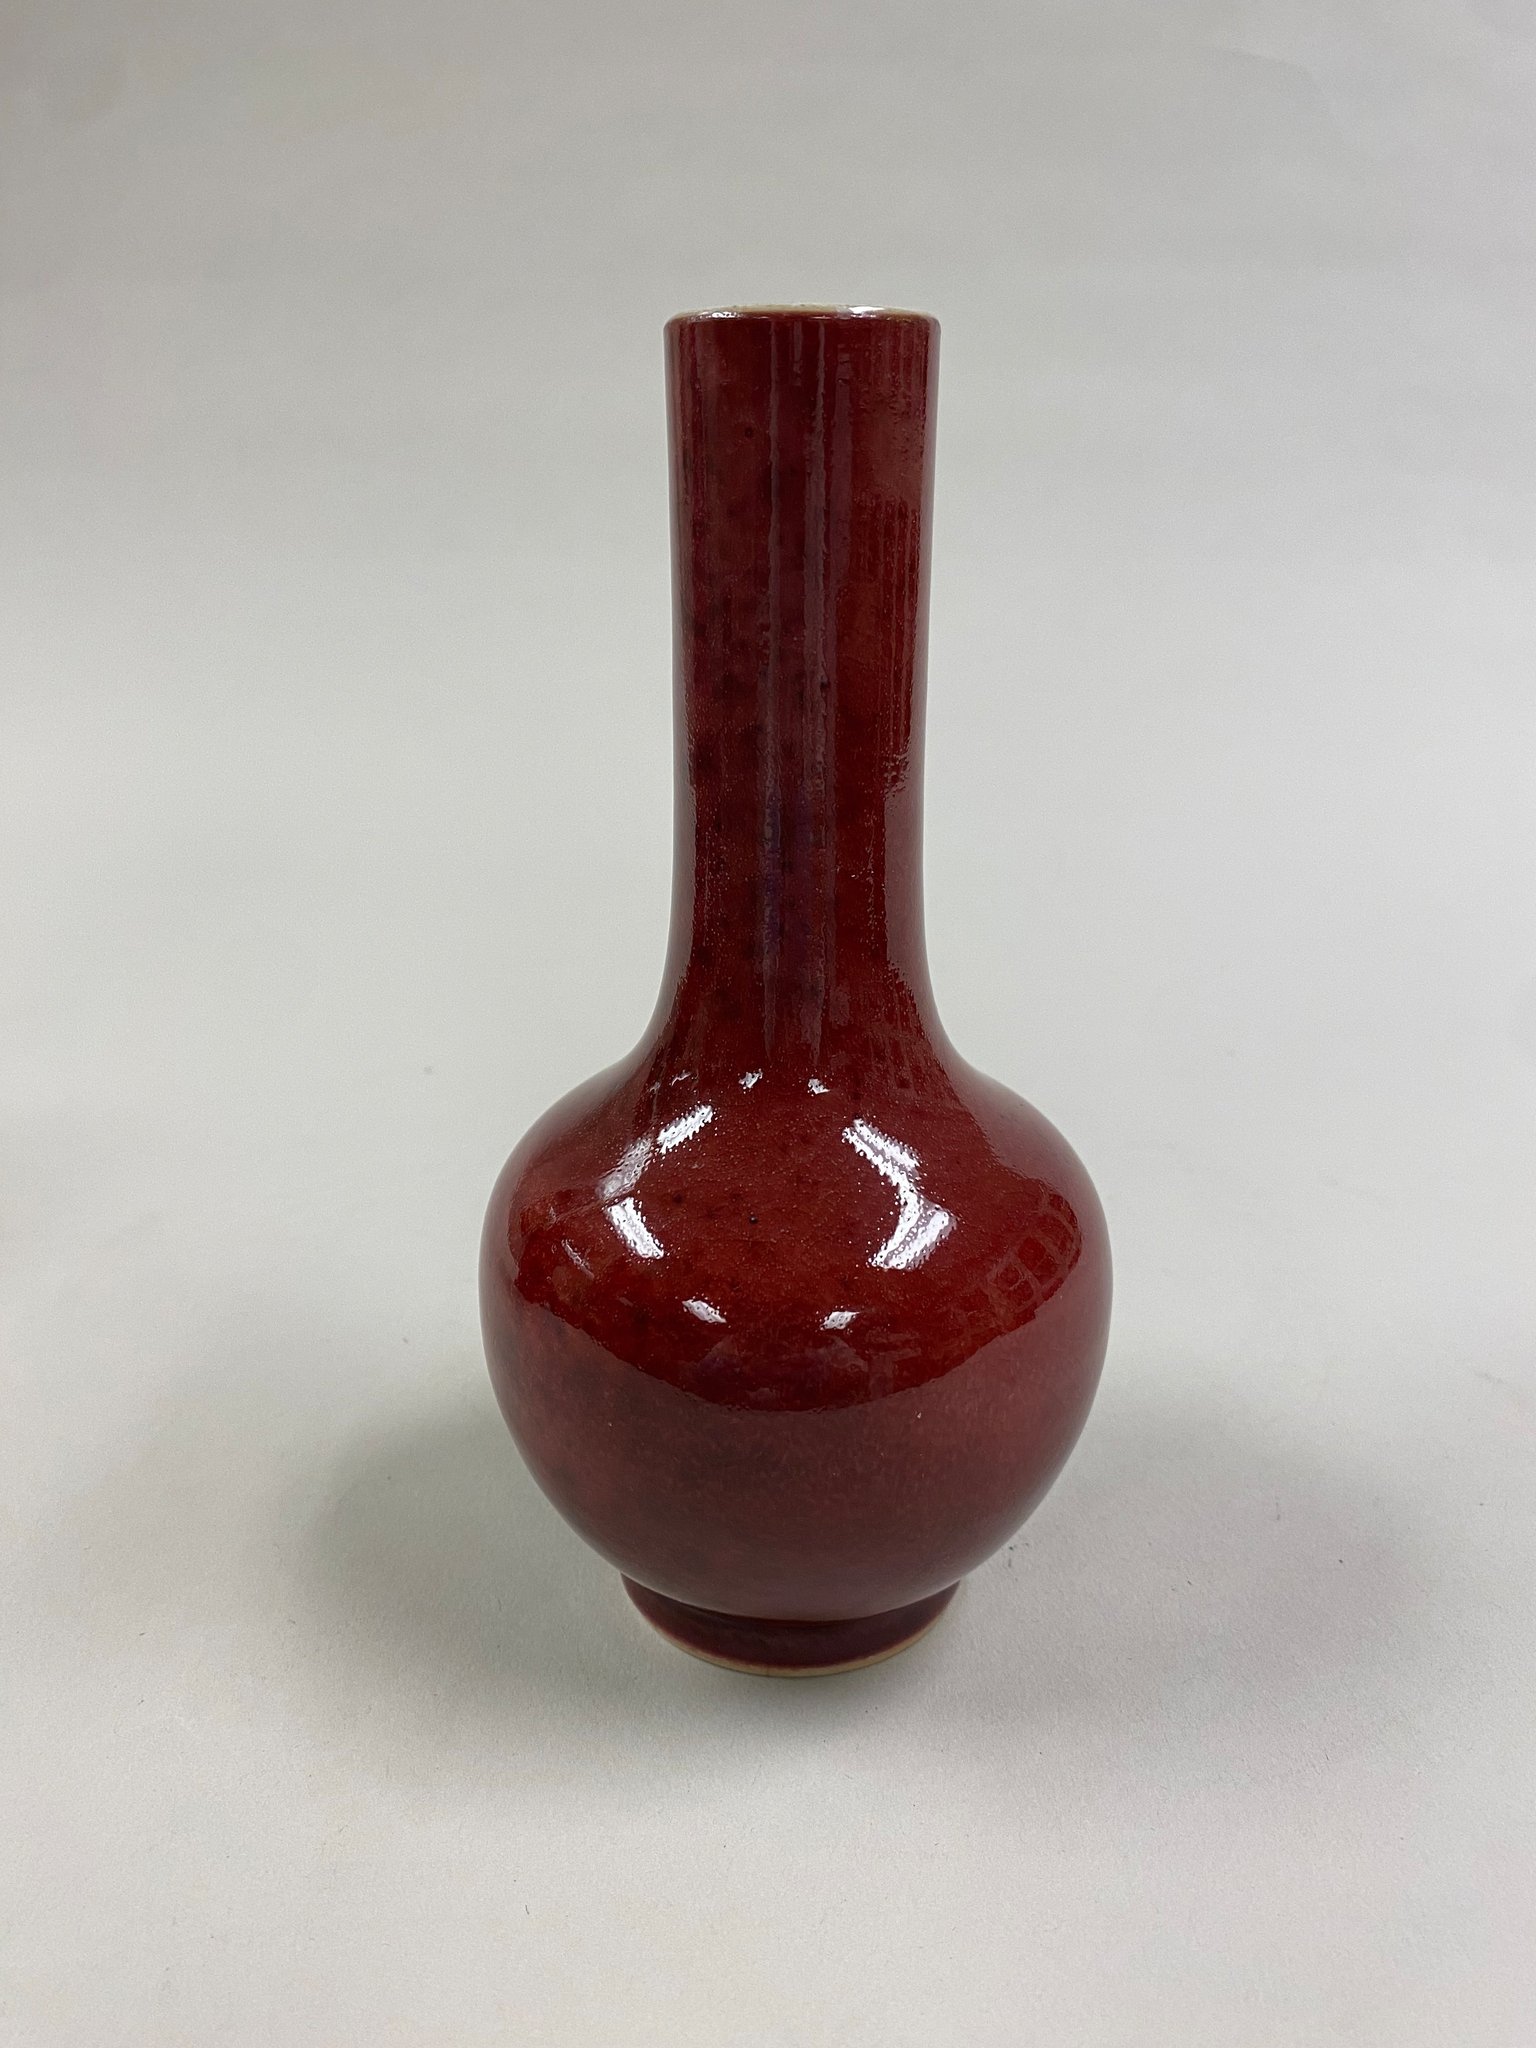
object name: bottle vase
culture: chinese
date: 1667-1733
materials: copper, glaze, porcelain